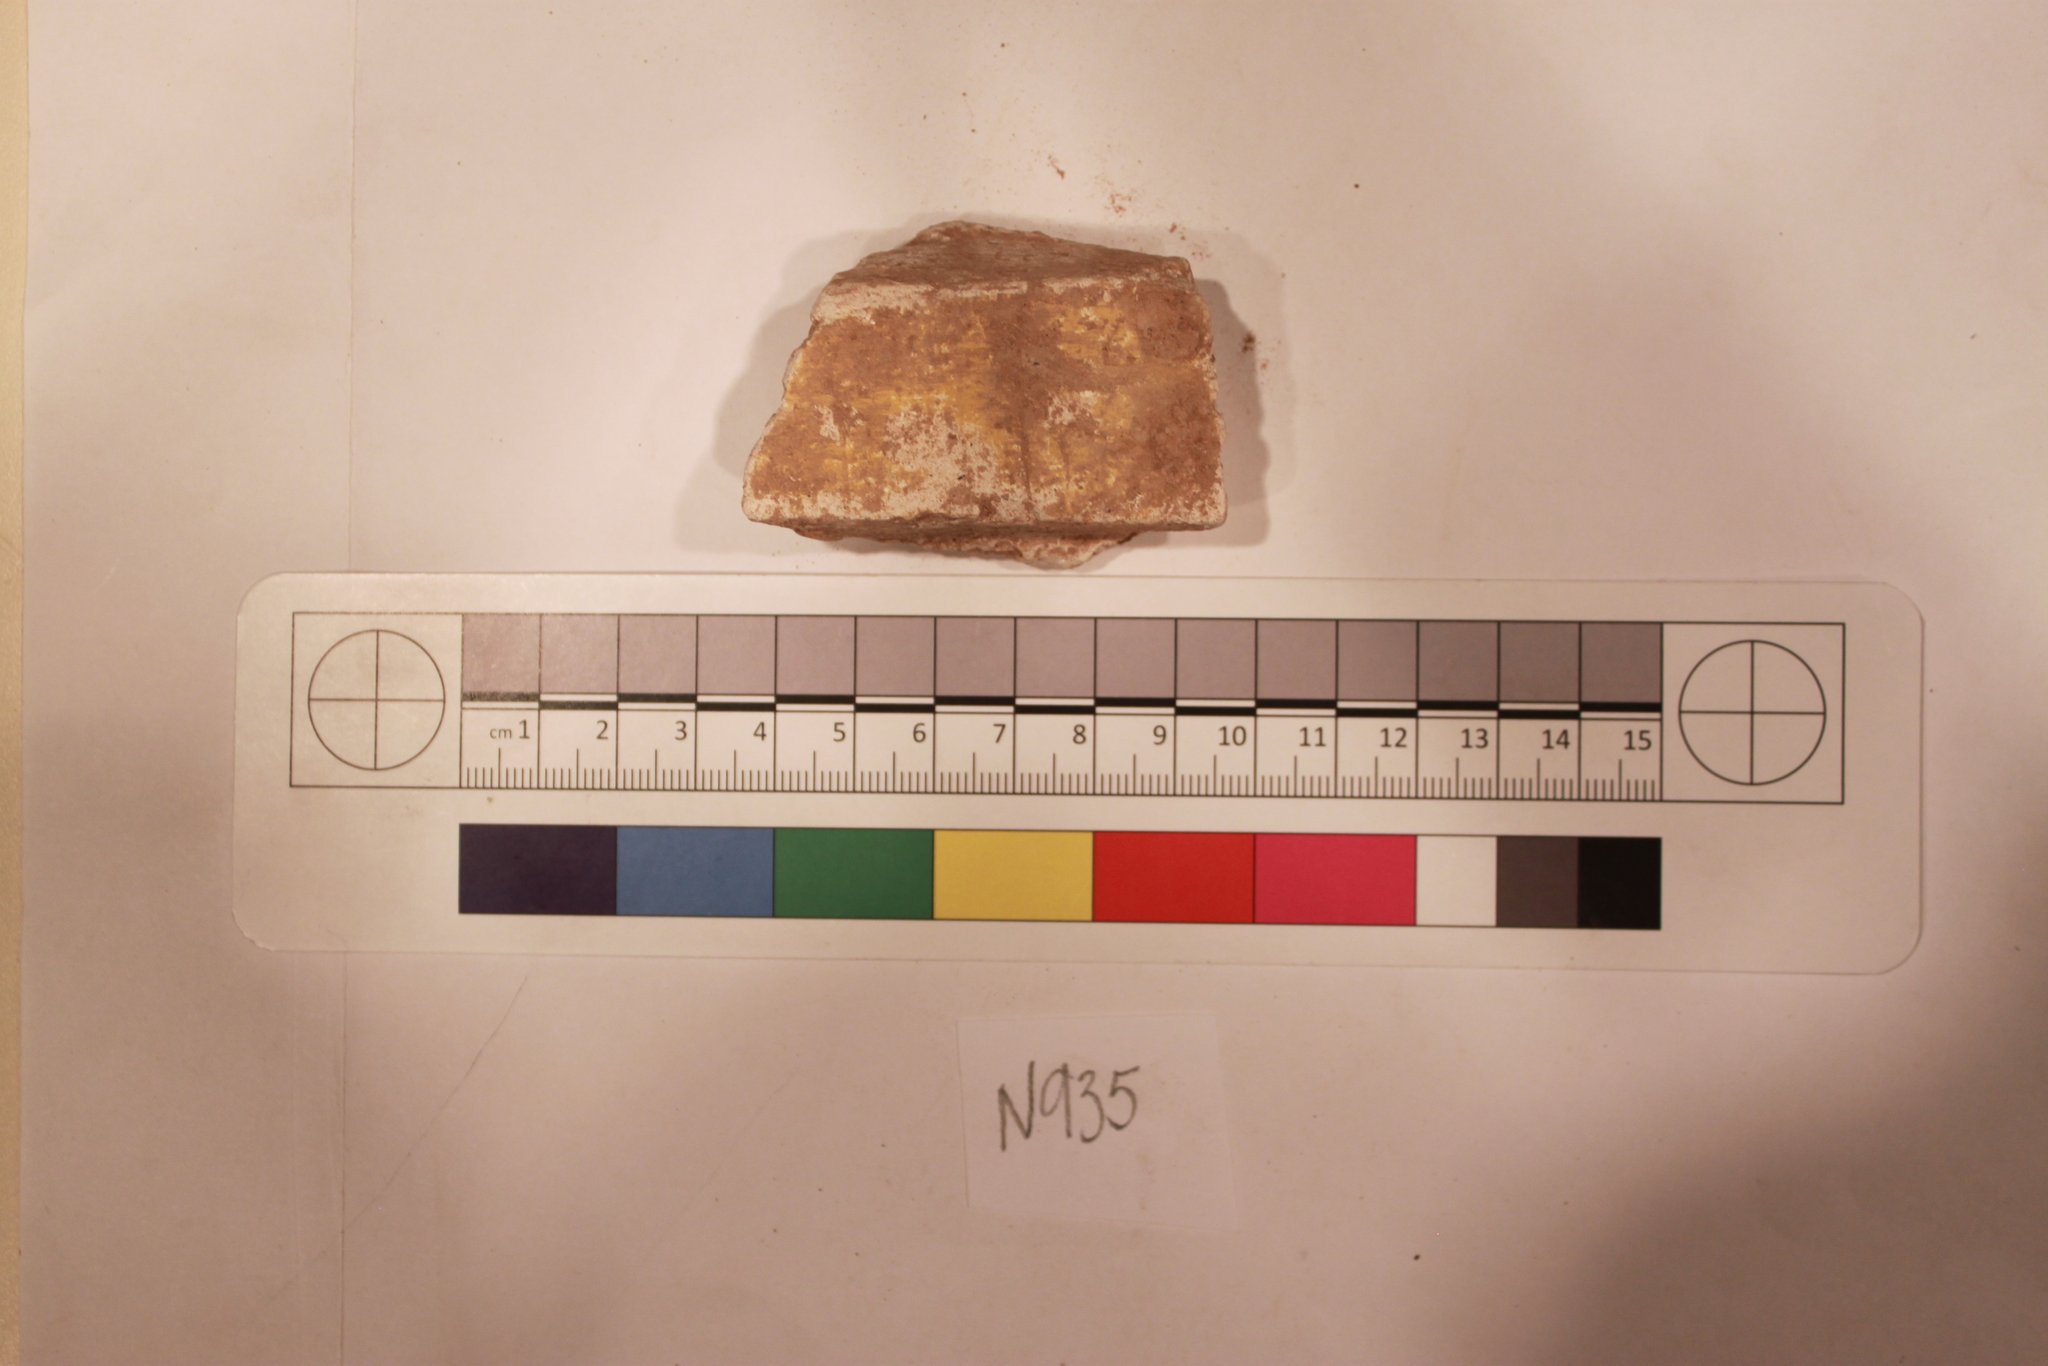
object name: fragment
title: Stucco Fragment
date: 701-1200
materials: plaster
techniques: carving, painting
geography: iran